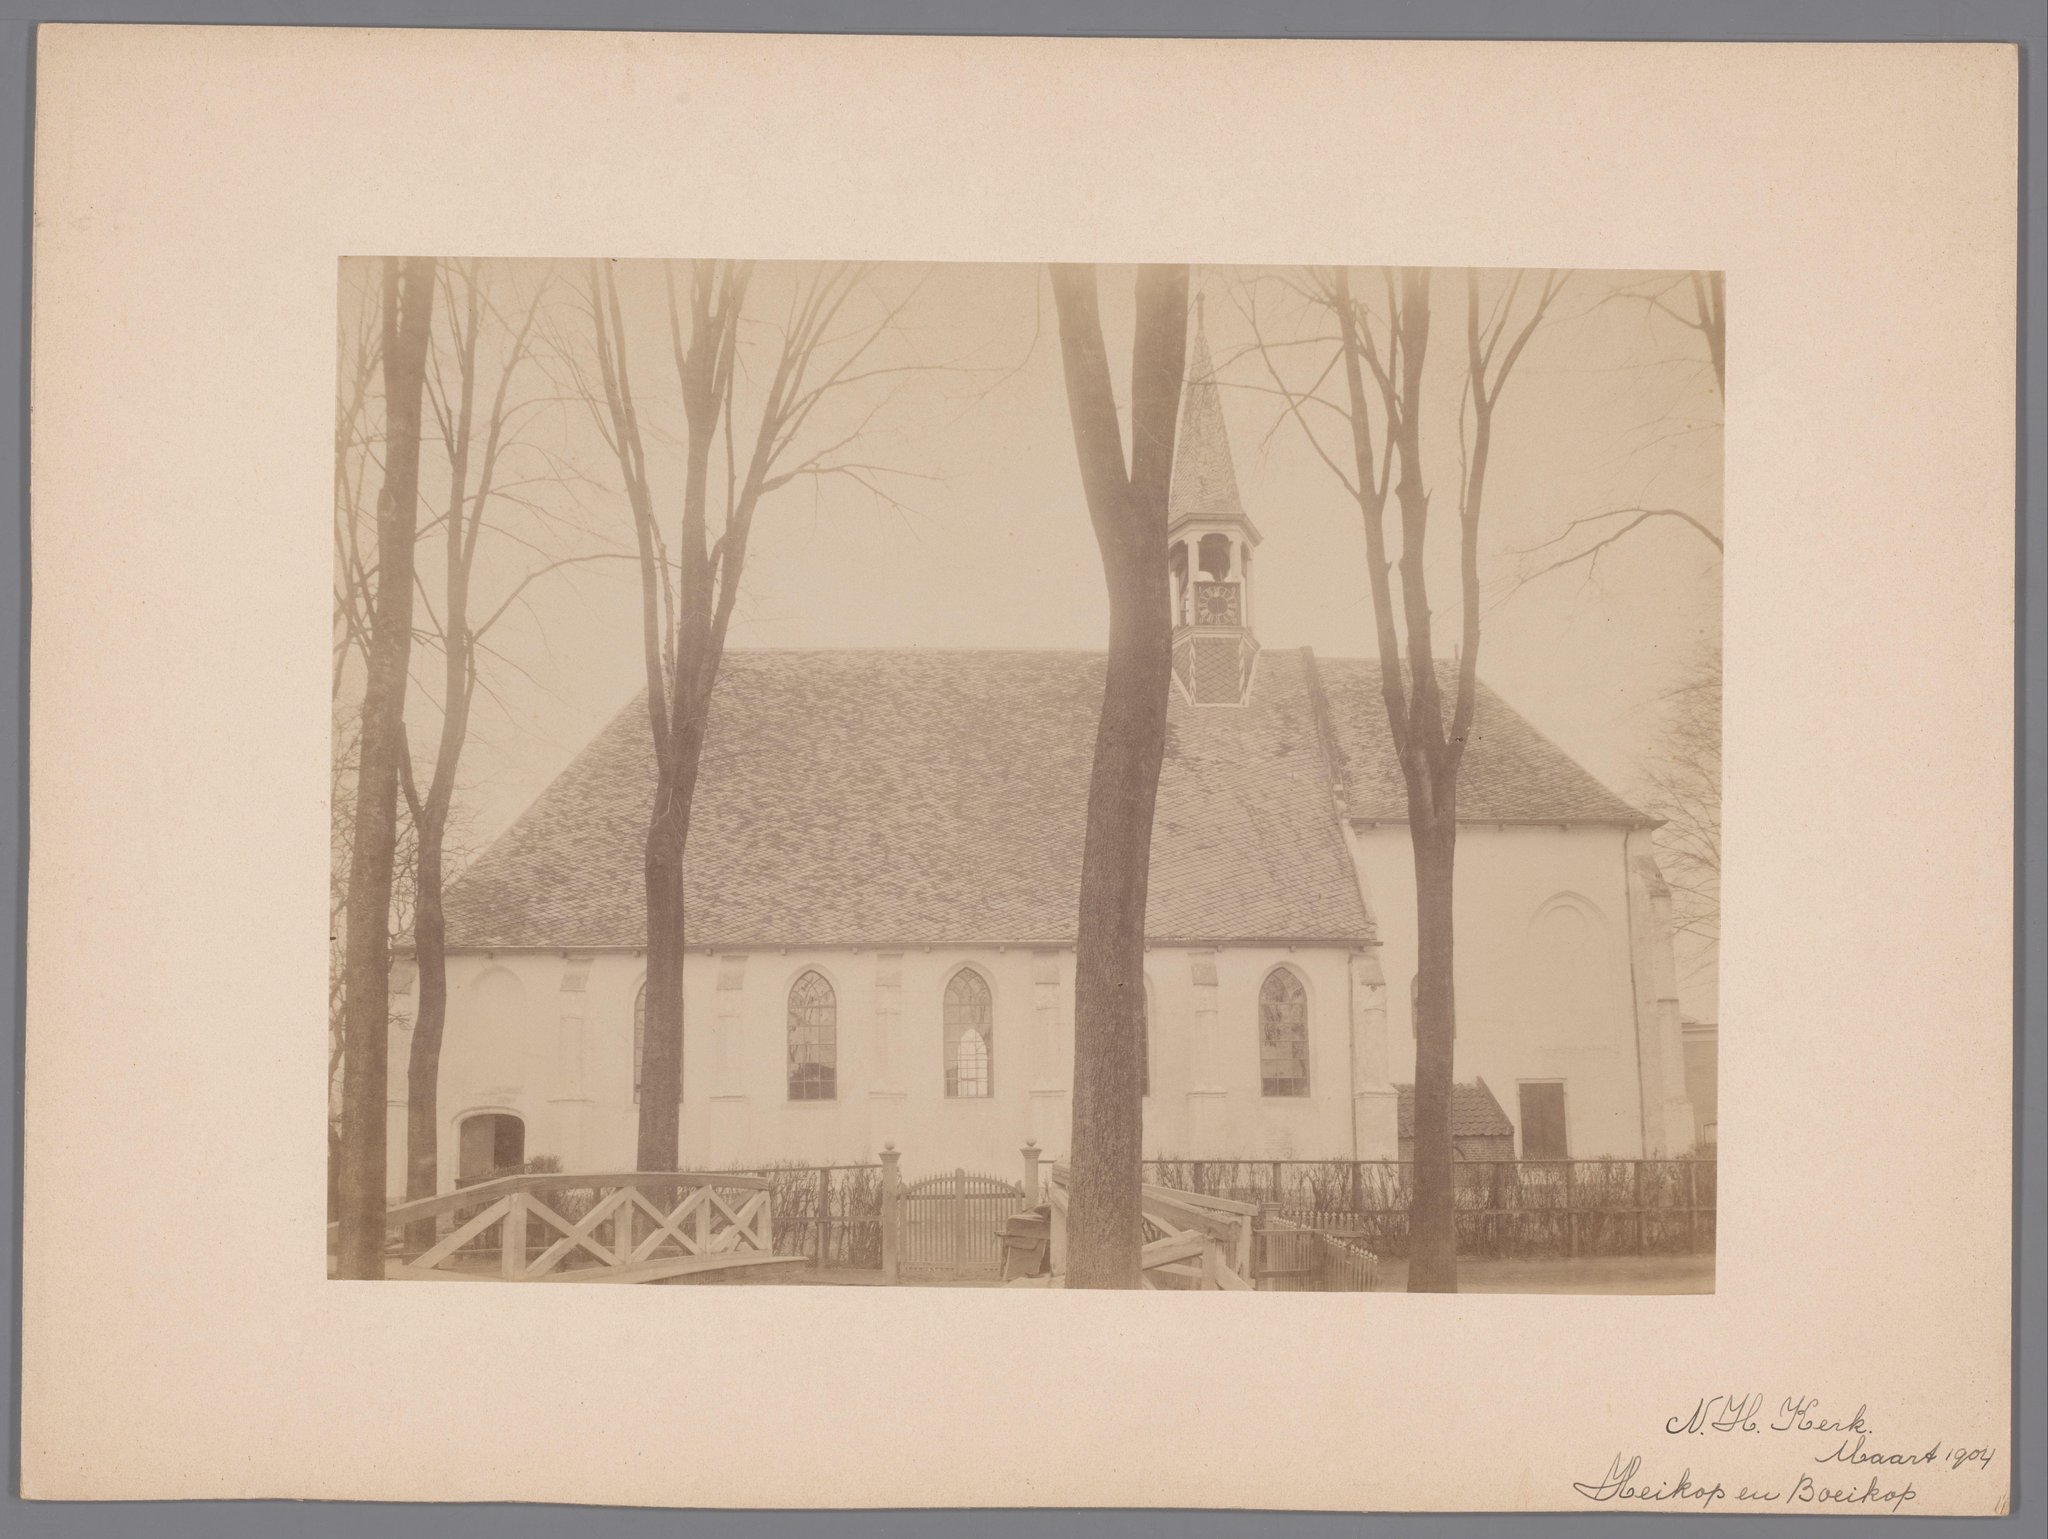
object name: photograph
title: Gezicht op de Hervormde Kerk te Hei- en Boeicop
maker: anoniem (monumentenzorg)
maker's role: fotograaf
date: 1904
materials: cardboard, photographic support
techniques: albumen print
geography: hei- en boeicop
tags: church (exterior)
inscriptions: annotation: ‘N.H. Kerk/ Maart 1904/ Hoeikop en Boeikop’, annotation: ‘Hei & Boeikop (Z.H.)/ N.H. kerk/ Maart 1904’